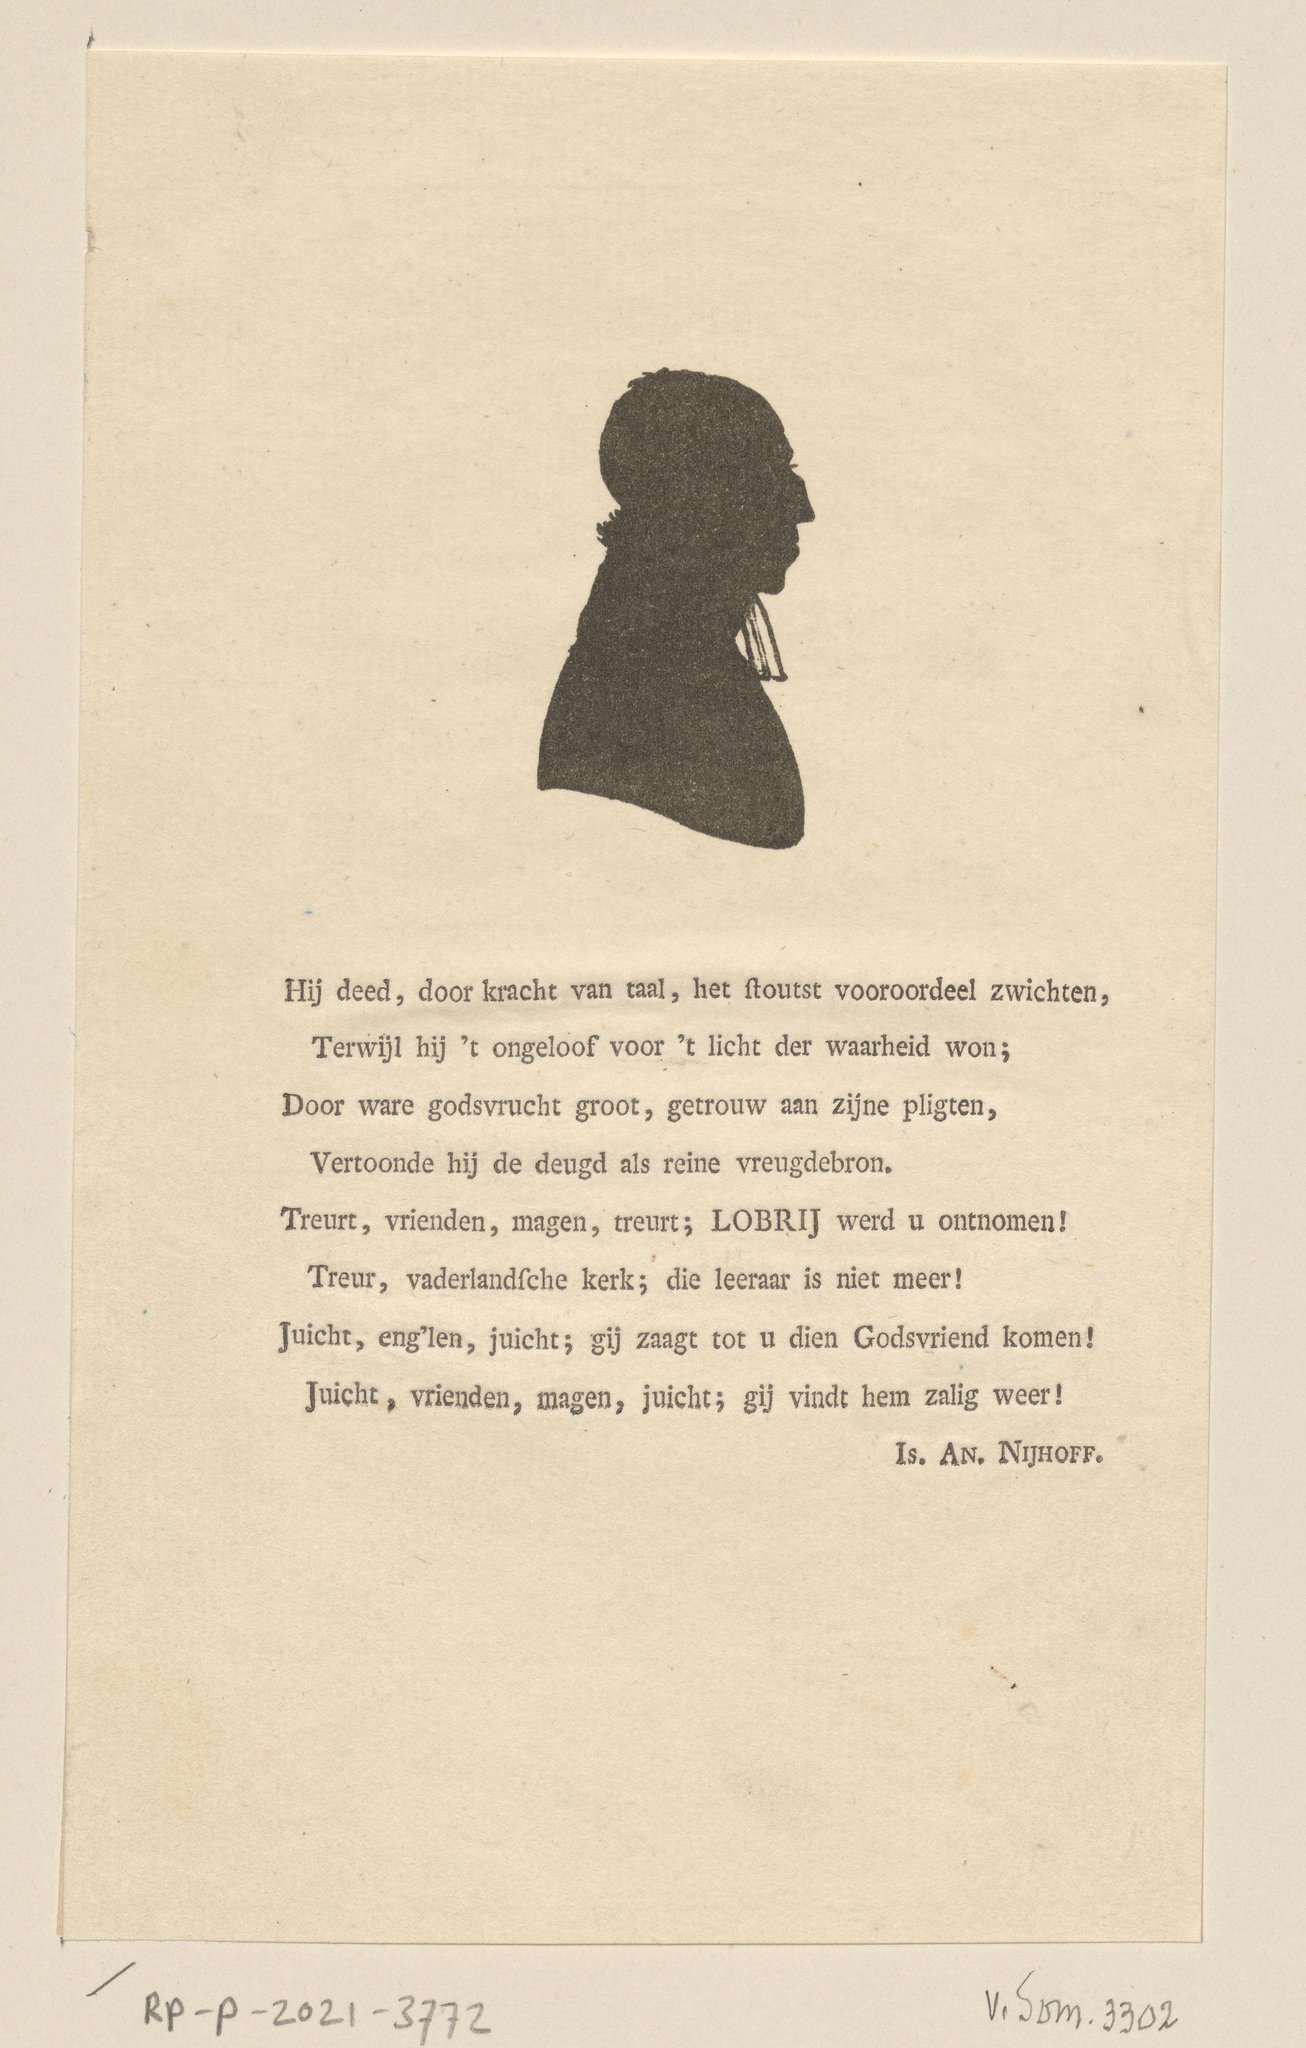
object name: book illustration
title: Silhouetportret van Nicolaas Lobry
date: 1818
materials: paper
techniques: letterpress printing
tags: historical persons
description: Prent waarschijnlijk uit: Lobry, Nicolaas. Nagelatene leerredenen. Arnhem: Paulus Nijhoff, 1818.